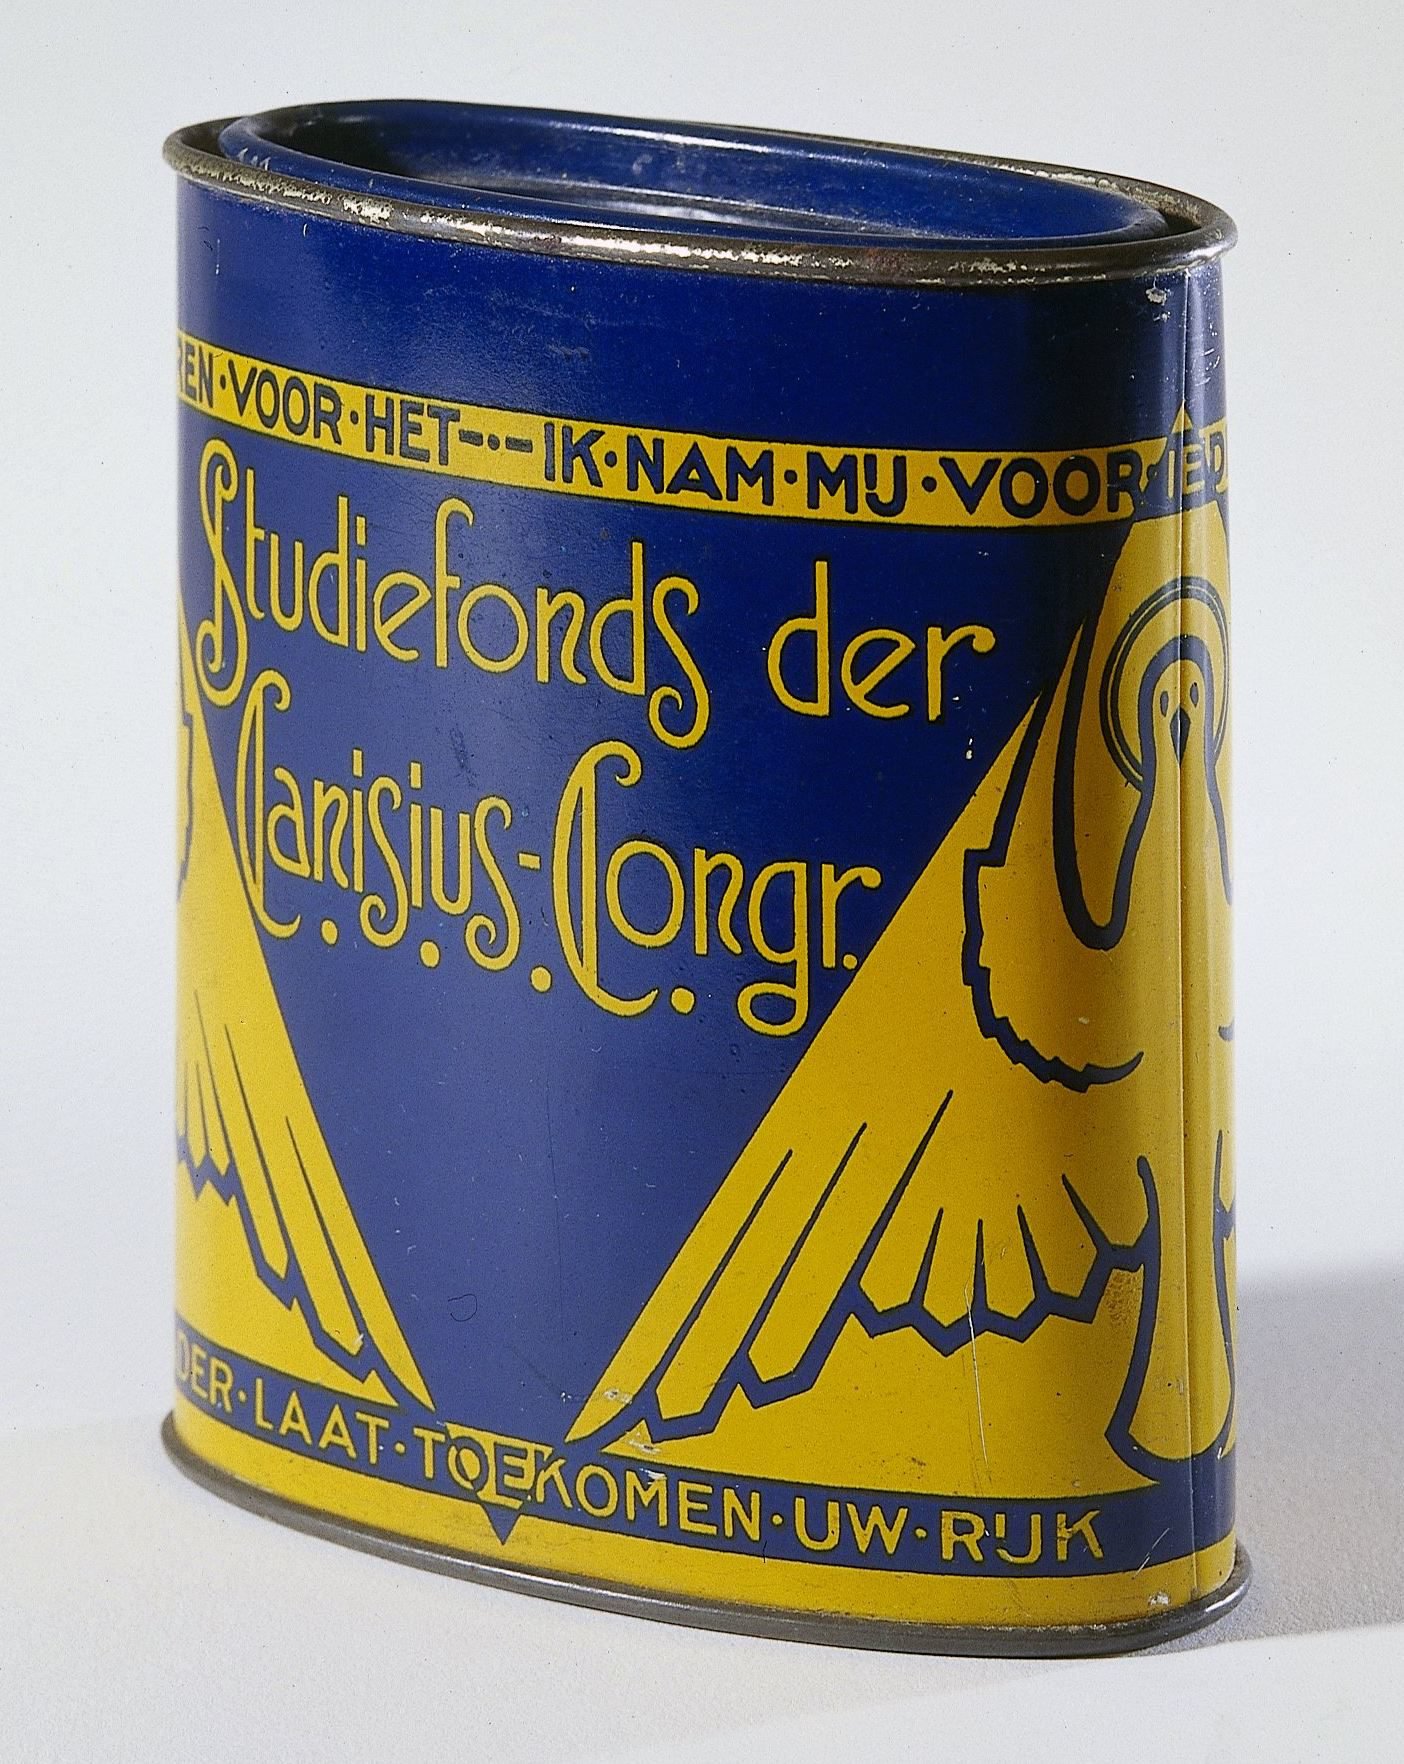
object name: bank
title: Collectebus voor het studiefonds van de Canisius Congregatie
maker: Anonymous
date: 1930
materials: metal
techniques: spray painted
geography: netherlands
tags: netherlands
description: Collection box of the Canisius Congregation study fund. ‘I have resolved to save at least one guilder a year for the ...’. c. 1930. The Canisius Congregation was founded in 1871 in Maastricht by and for the benefit of Catholic workers. The study fund enabled novices preparing for missionary work as priests to build up savings: 2 cents a week, 10 cents a month, 25 cents a quarter or one guilder a year.